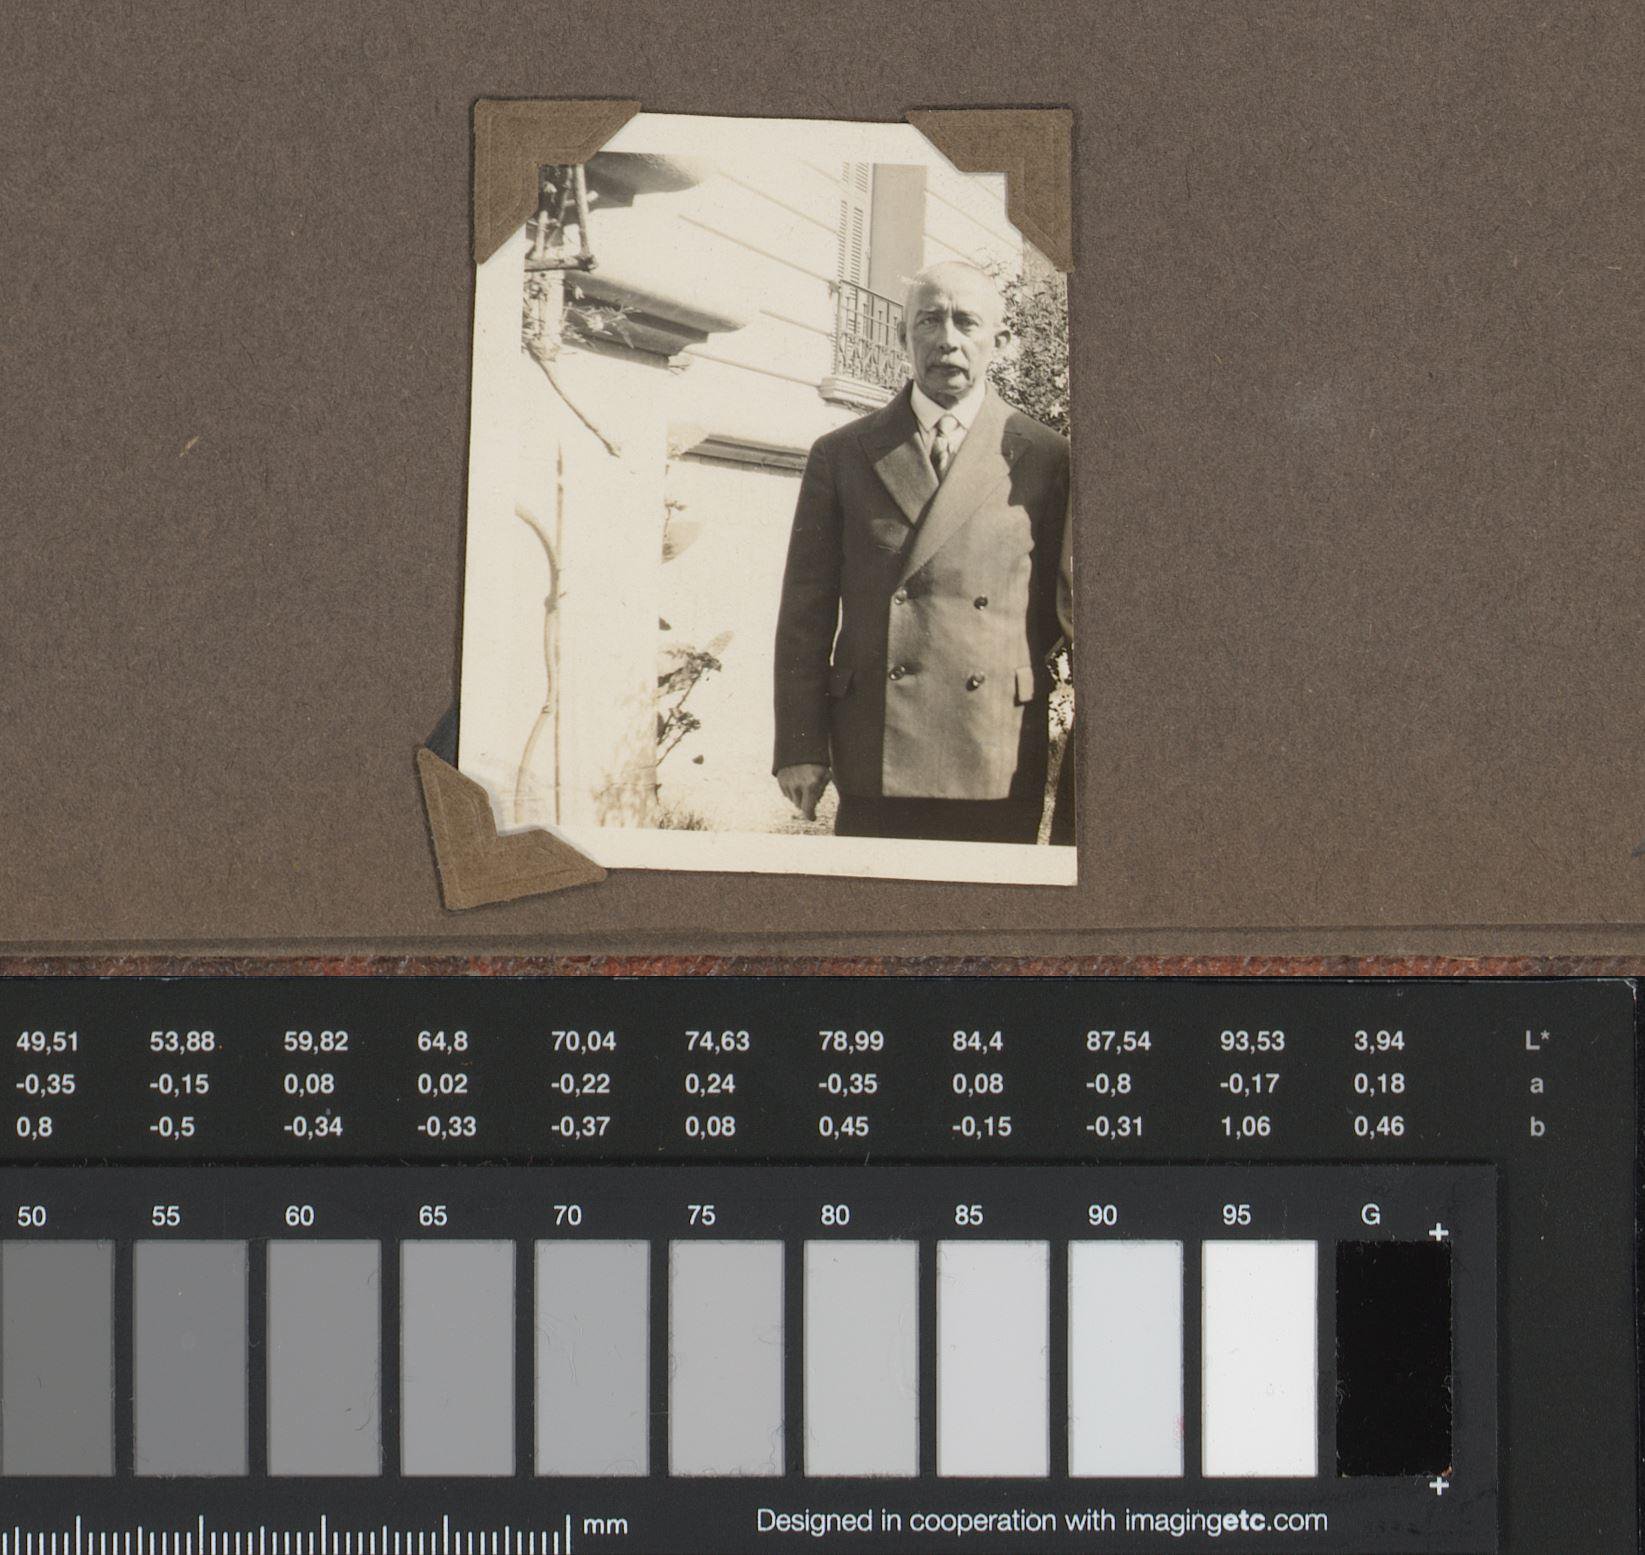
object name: album leaf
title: Portret van Meinard Dorus Mijer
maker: Anonymous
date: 1940-1950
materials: paper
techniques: gelatin silver print, snipping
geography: netherlands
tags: batavia, adult man, historical persons, netherlands